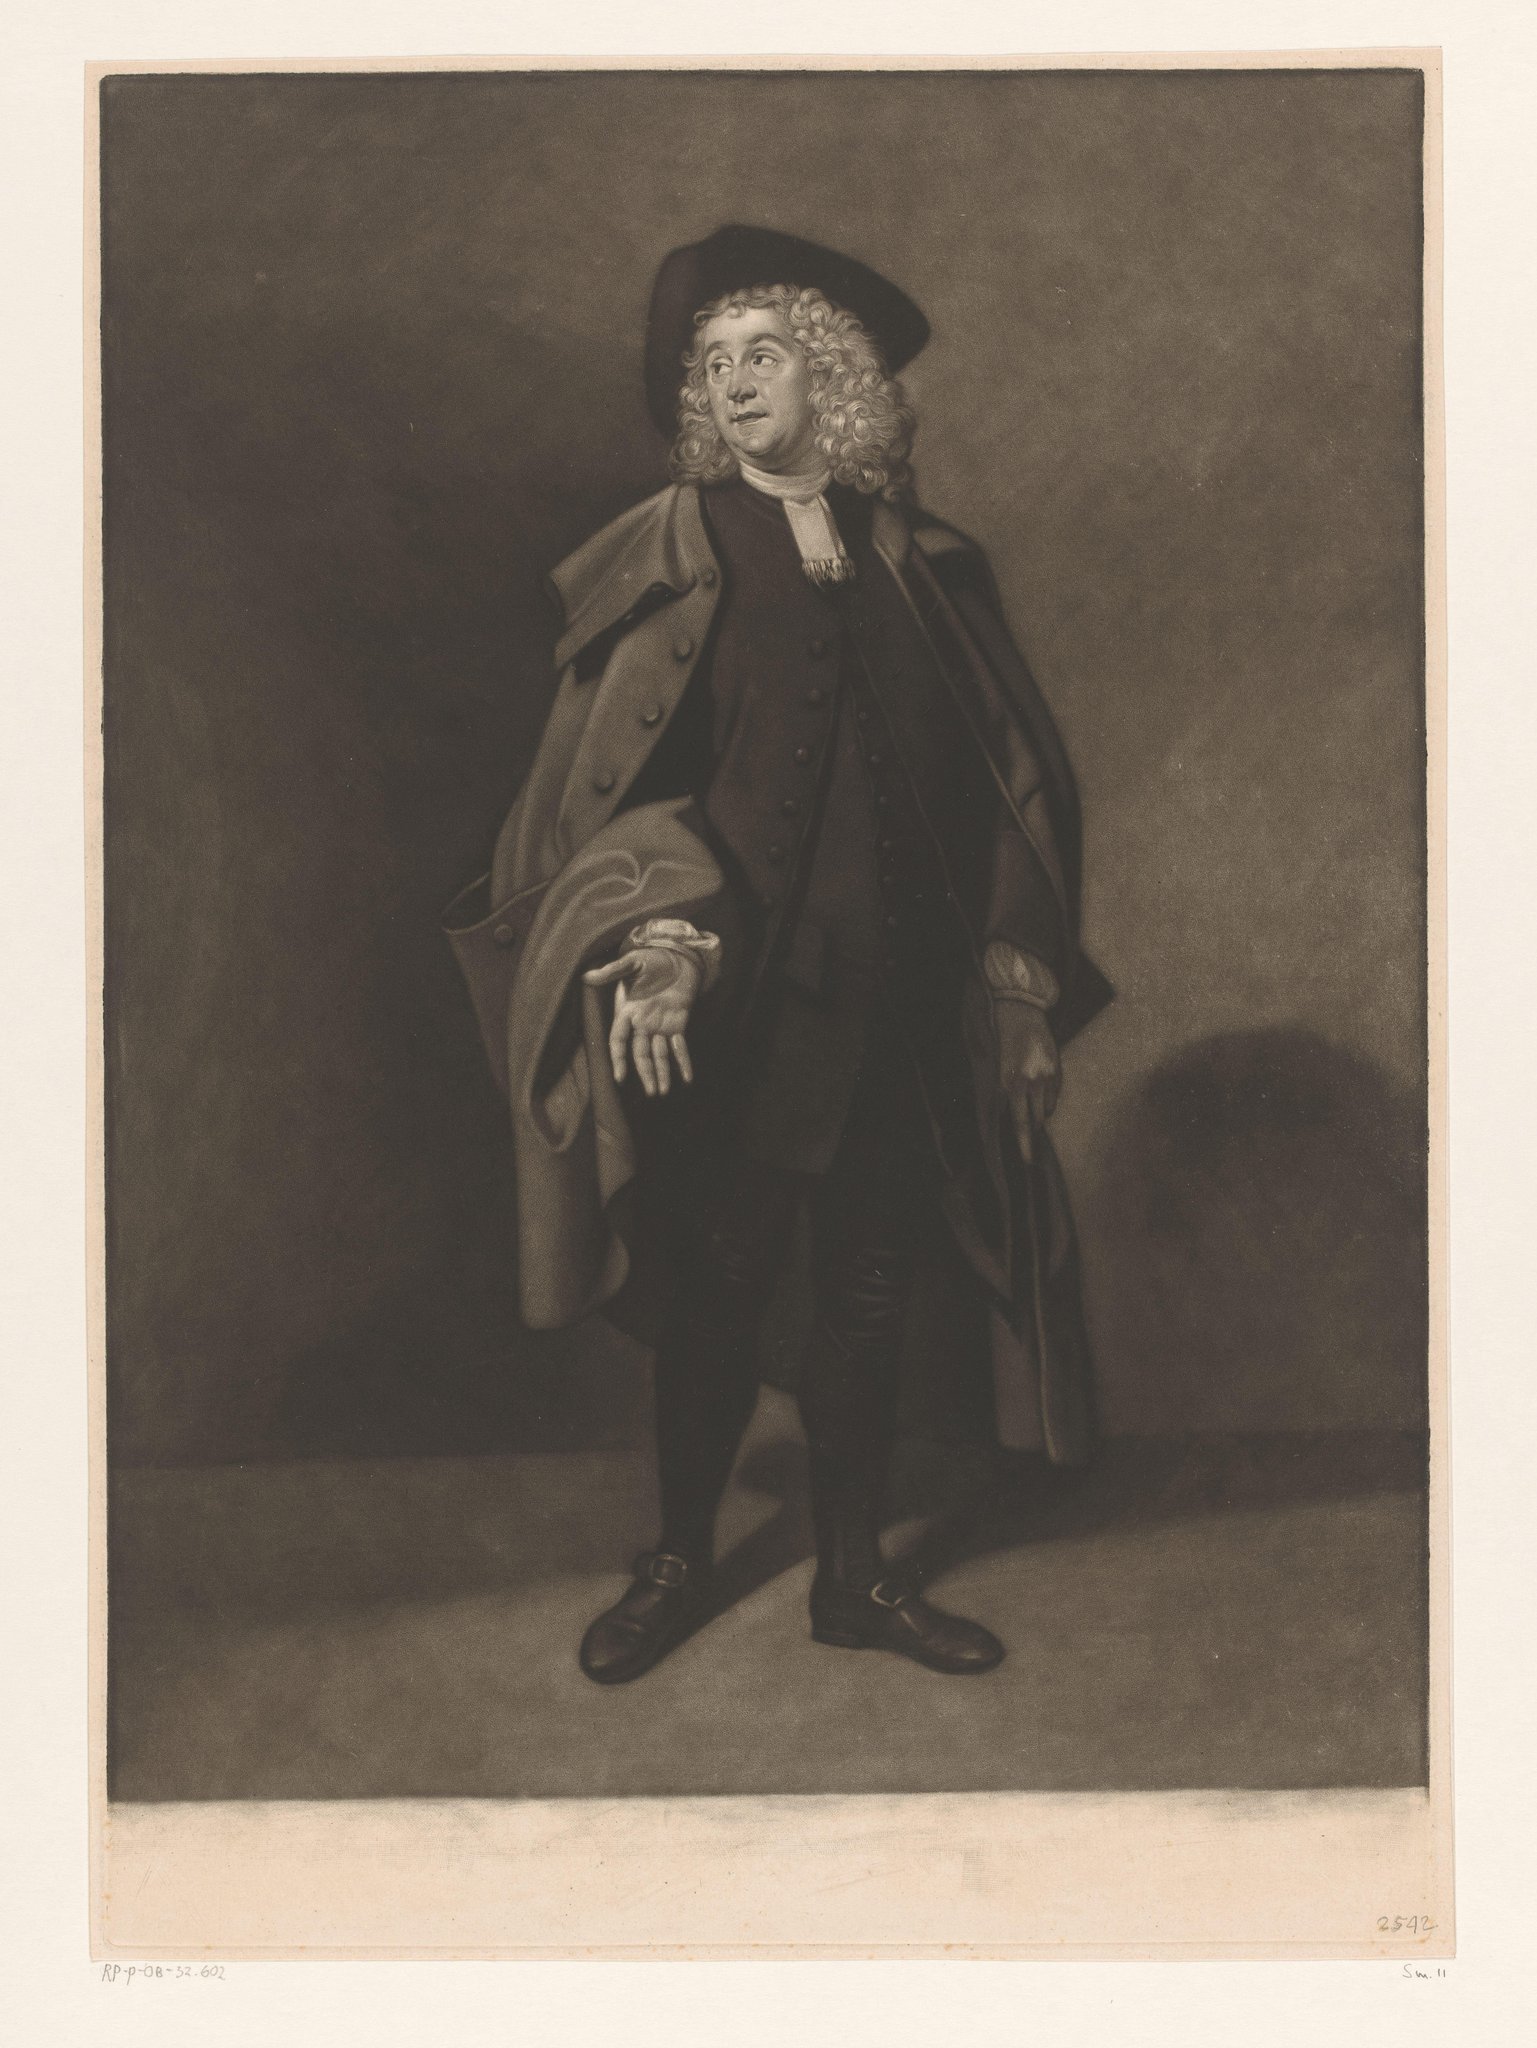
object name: print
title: Portret van John Moody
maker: giuseppe filippo liberati marchi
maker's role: print maker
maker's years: 1734-1808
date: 1744-1808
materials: paper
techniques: mezzotint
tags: historical persons, portrait of actor, actress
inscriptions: collector's mark: Lugt 240